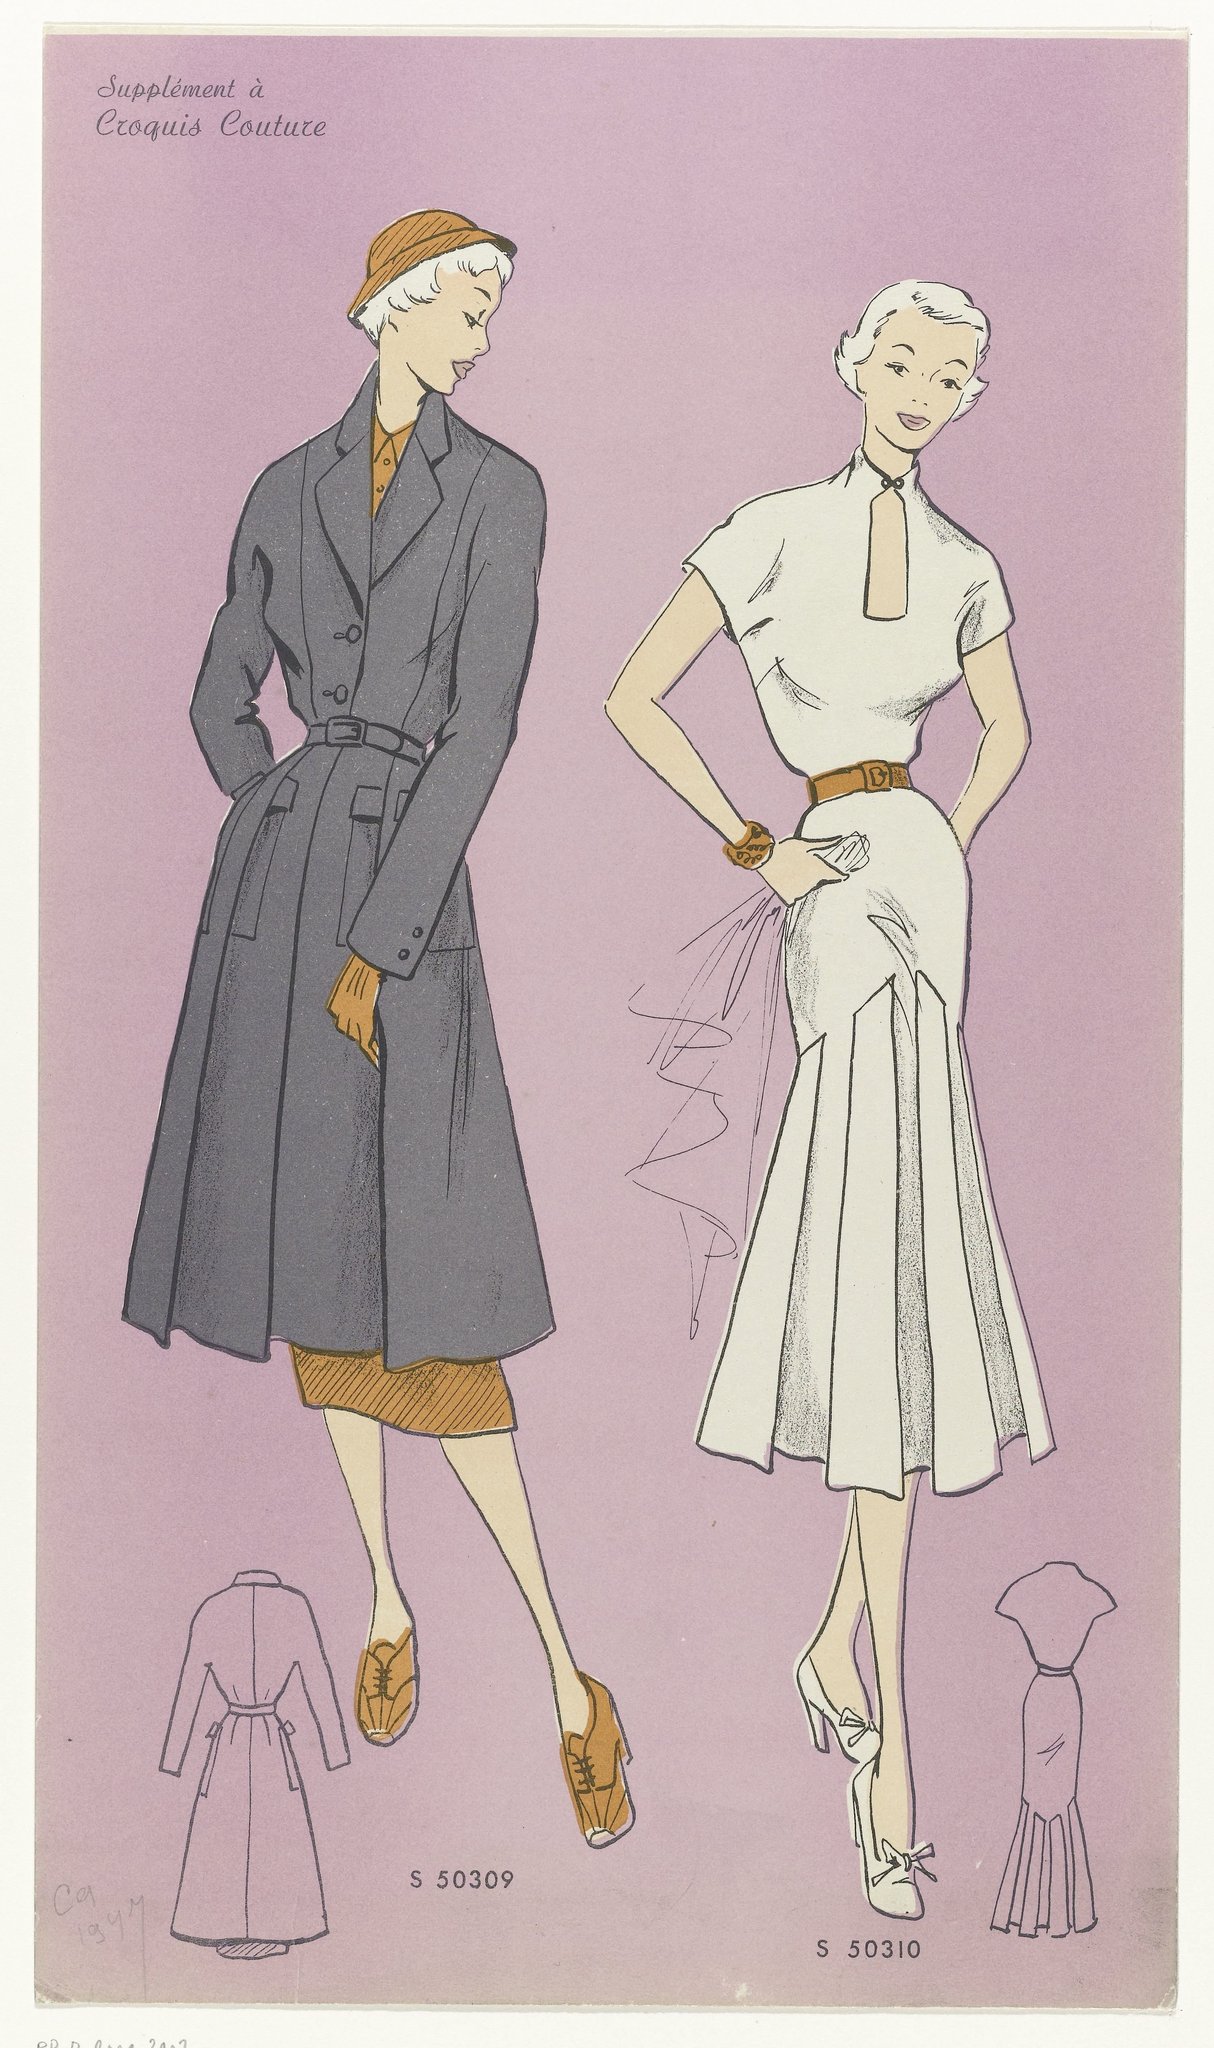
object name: fashion print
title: Croquis Couture, No. S 50309 en S 50310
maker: Anonymous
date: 1947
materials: paper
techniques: hand coloring, lithograph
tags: coat (+ women's clothes), head-gear (+ women's clothes), fashion plates, shoes, sandals (+ women's clothes), gloves, mittens, etc. (+ women's clothes), dress, gown (+ women's clothes), belt, girdle, waistband (+ women's clothes)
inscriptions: title: ‘Supplément à Croquis Couture’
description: Links: grijze mantel over bruine rok; rechts een witte japon met smalle ceintuur.